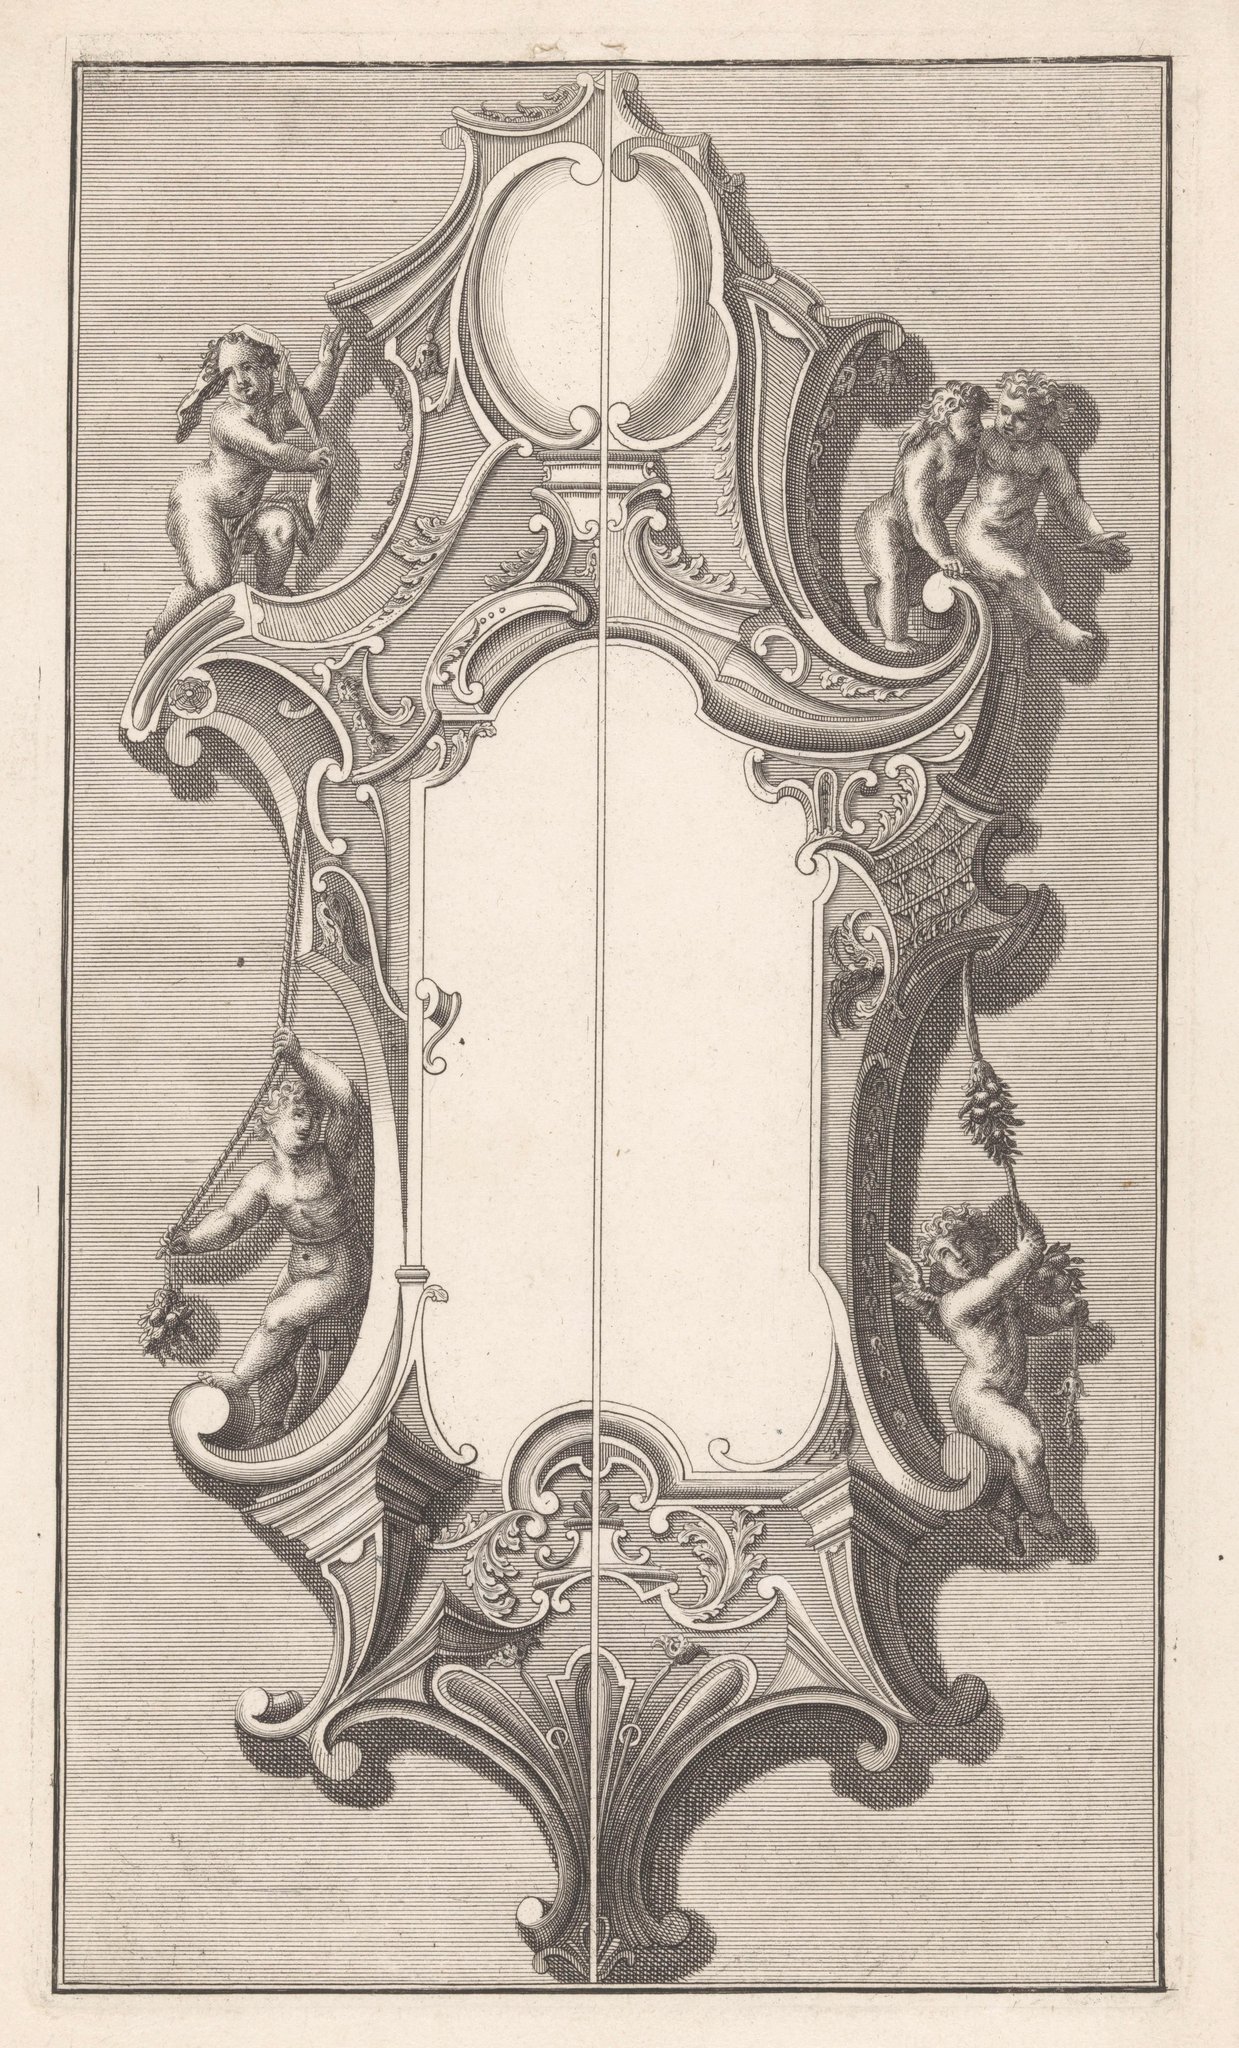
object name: ornament print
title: Cartouche met vijf putti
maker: Anonymous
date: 1700-1799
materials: paper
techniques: engraving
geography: germany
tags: ornament ~ cartouche, cupids: 'amores', 'amoretti', 'putti'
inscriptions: collector's mark: Lugt 2760, collector's mark: Lugt 2228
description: Een grote geornamenteerde cartouche met vijf putti met doeken en touwen.